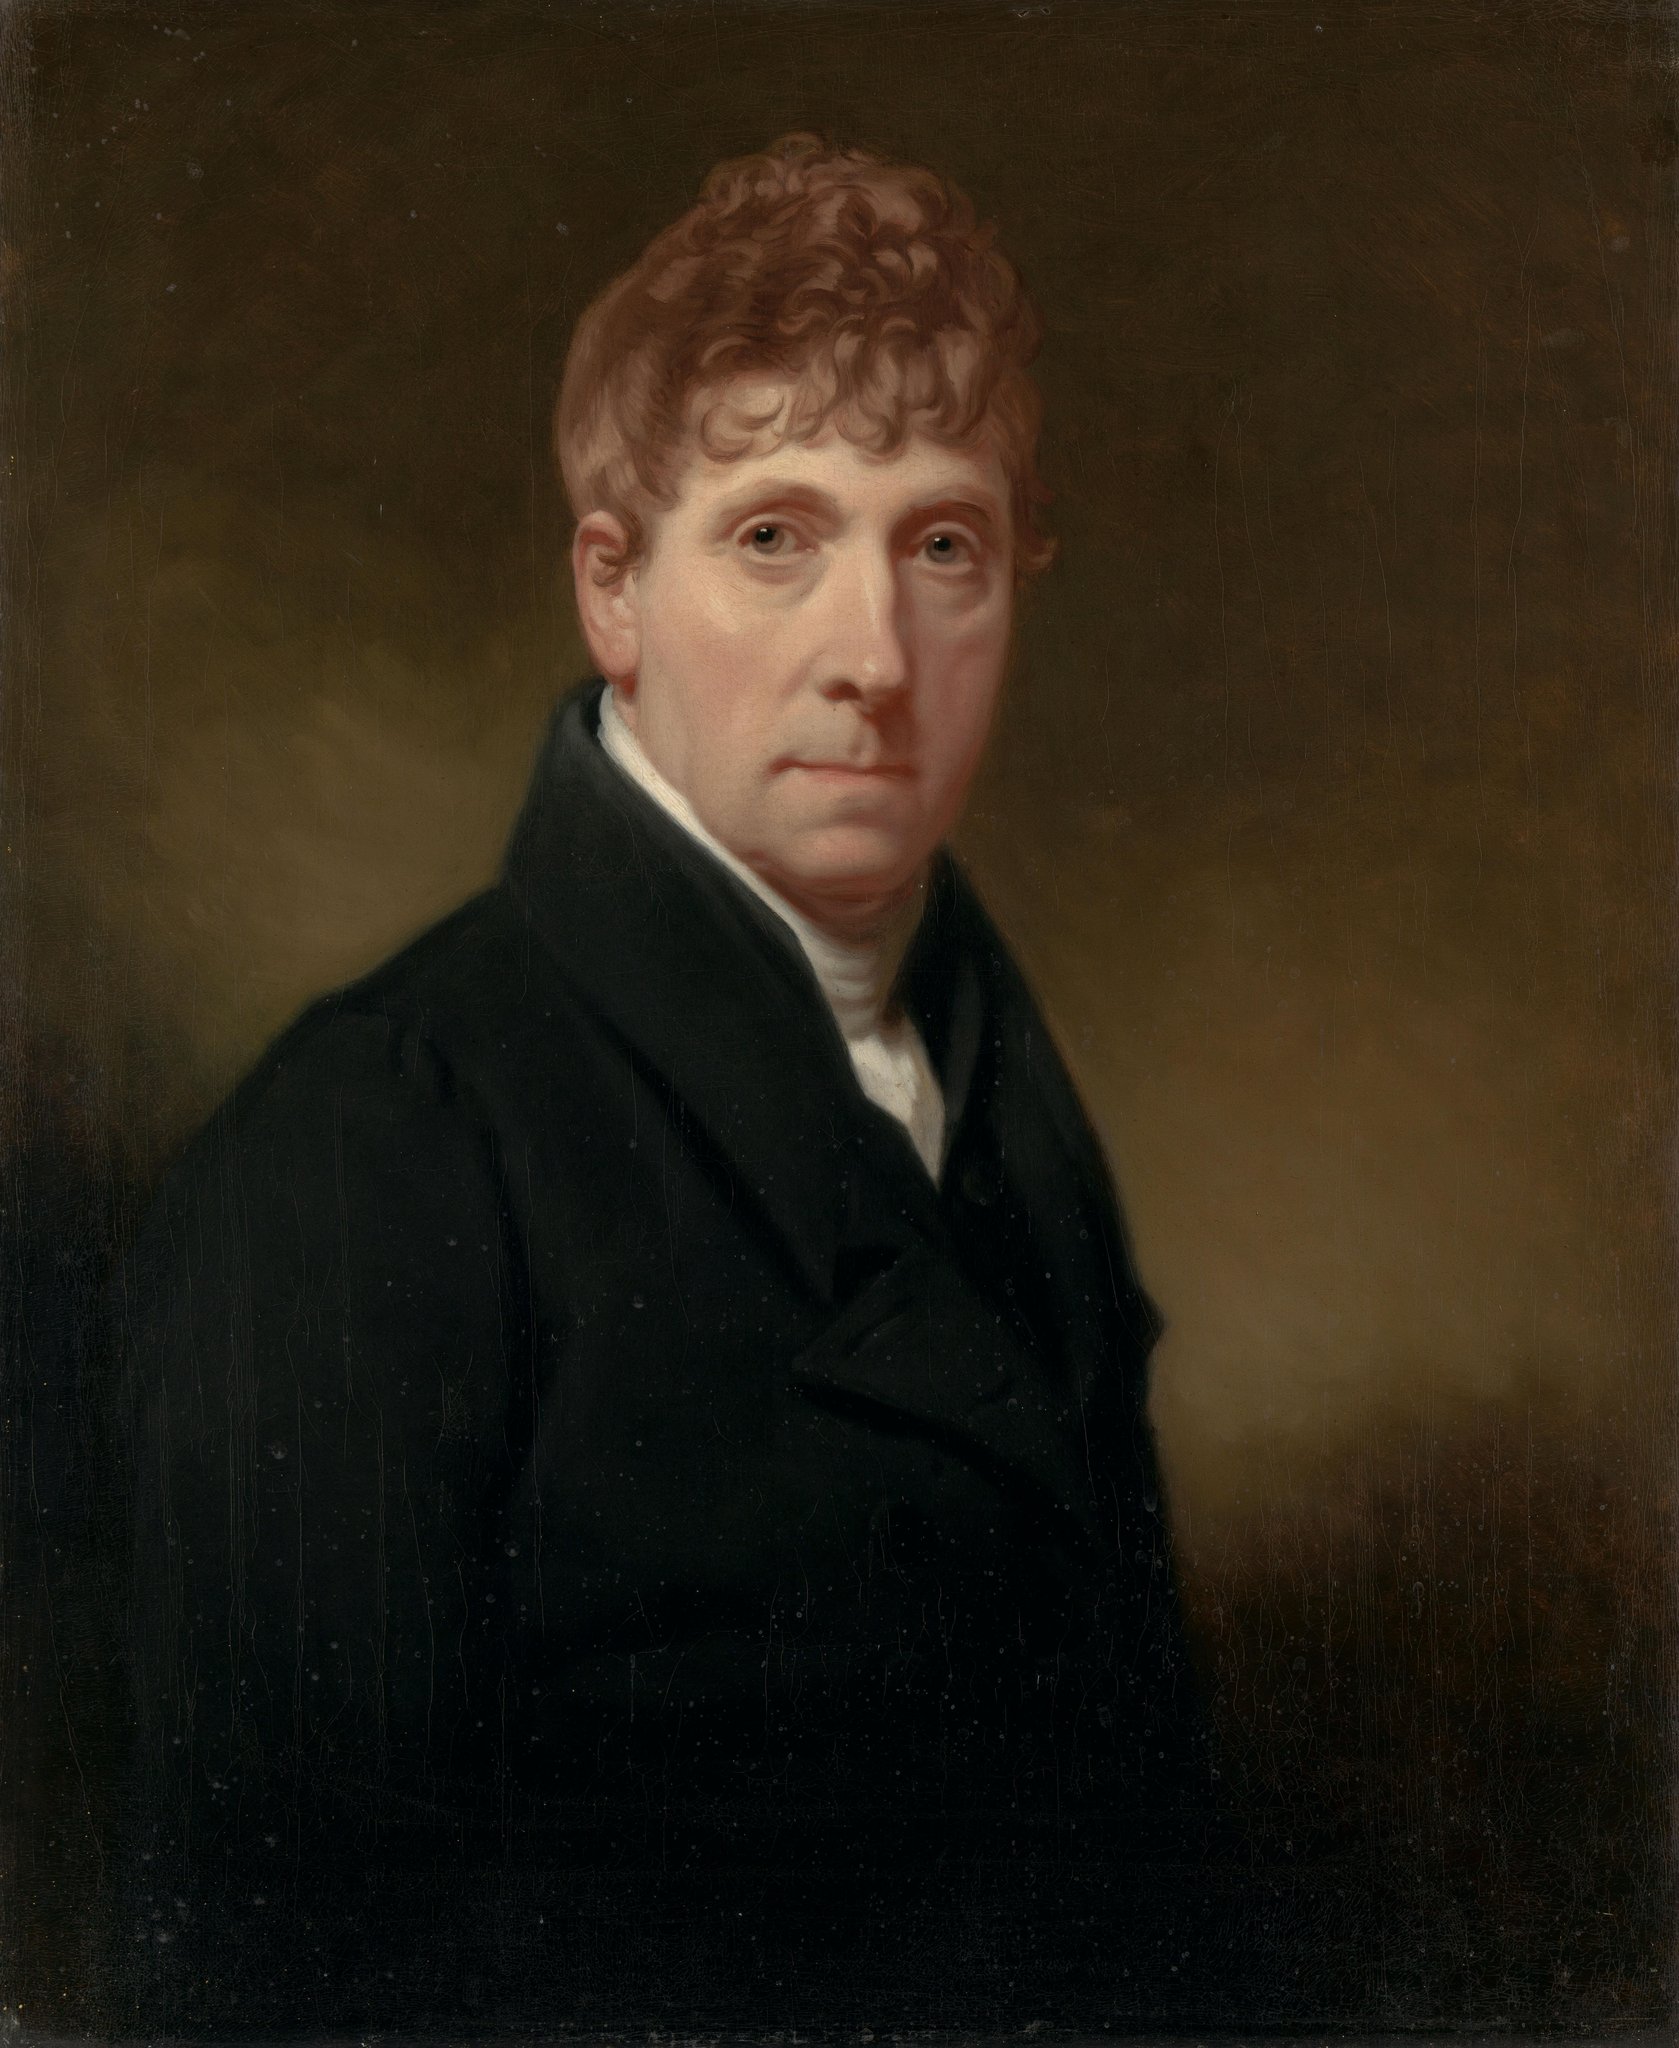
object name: painting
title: Self Portrait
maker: charles howard hodges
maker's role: draughtsman, painter, print maker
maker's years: 1764-1837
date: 1825-1830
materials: canvas, oil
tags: amsterdam, print maker, charles howard hodges, historical persons, portrait, self-portrait of painter, portrait, self-portrait of artist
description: The English painter Charles Howard Hodges settled in the Netherlands in 1792. He became a successful portraitist and received important commissions, such as the state portrait of Louis Napoleon in this gallery. In this self-portrait, he chose not to depict himself as a painter with easel and palette, but as a well-to-do citizen. The work was presented to the Rijksmuseum by Hodges’ daughter Emma, whose portrait hangs nearby.